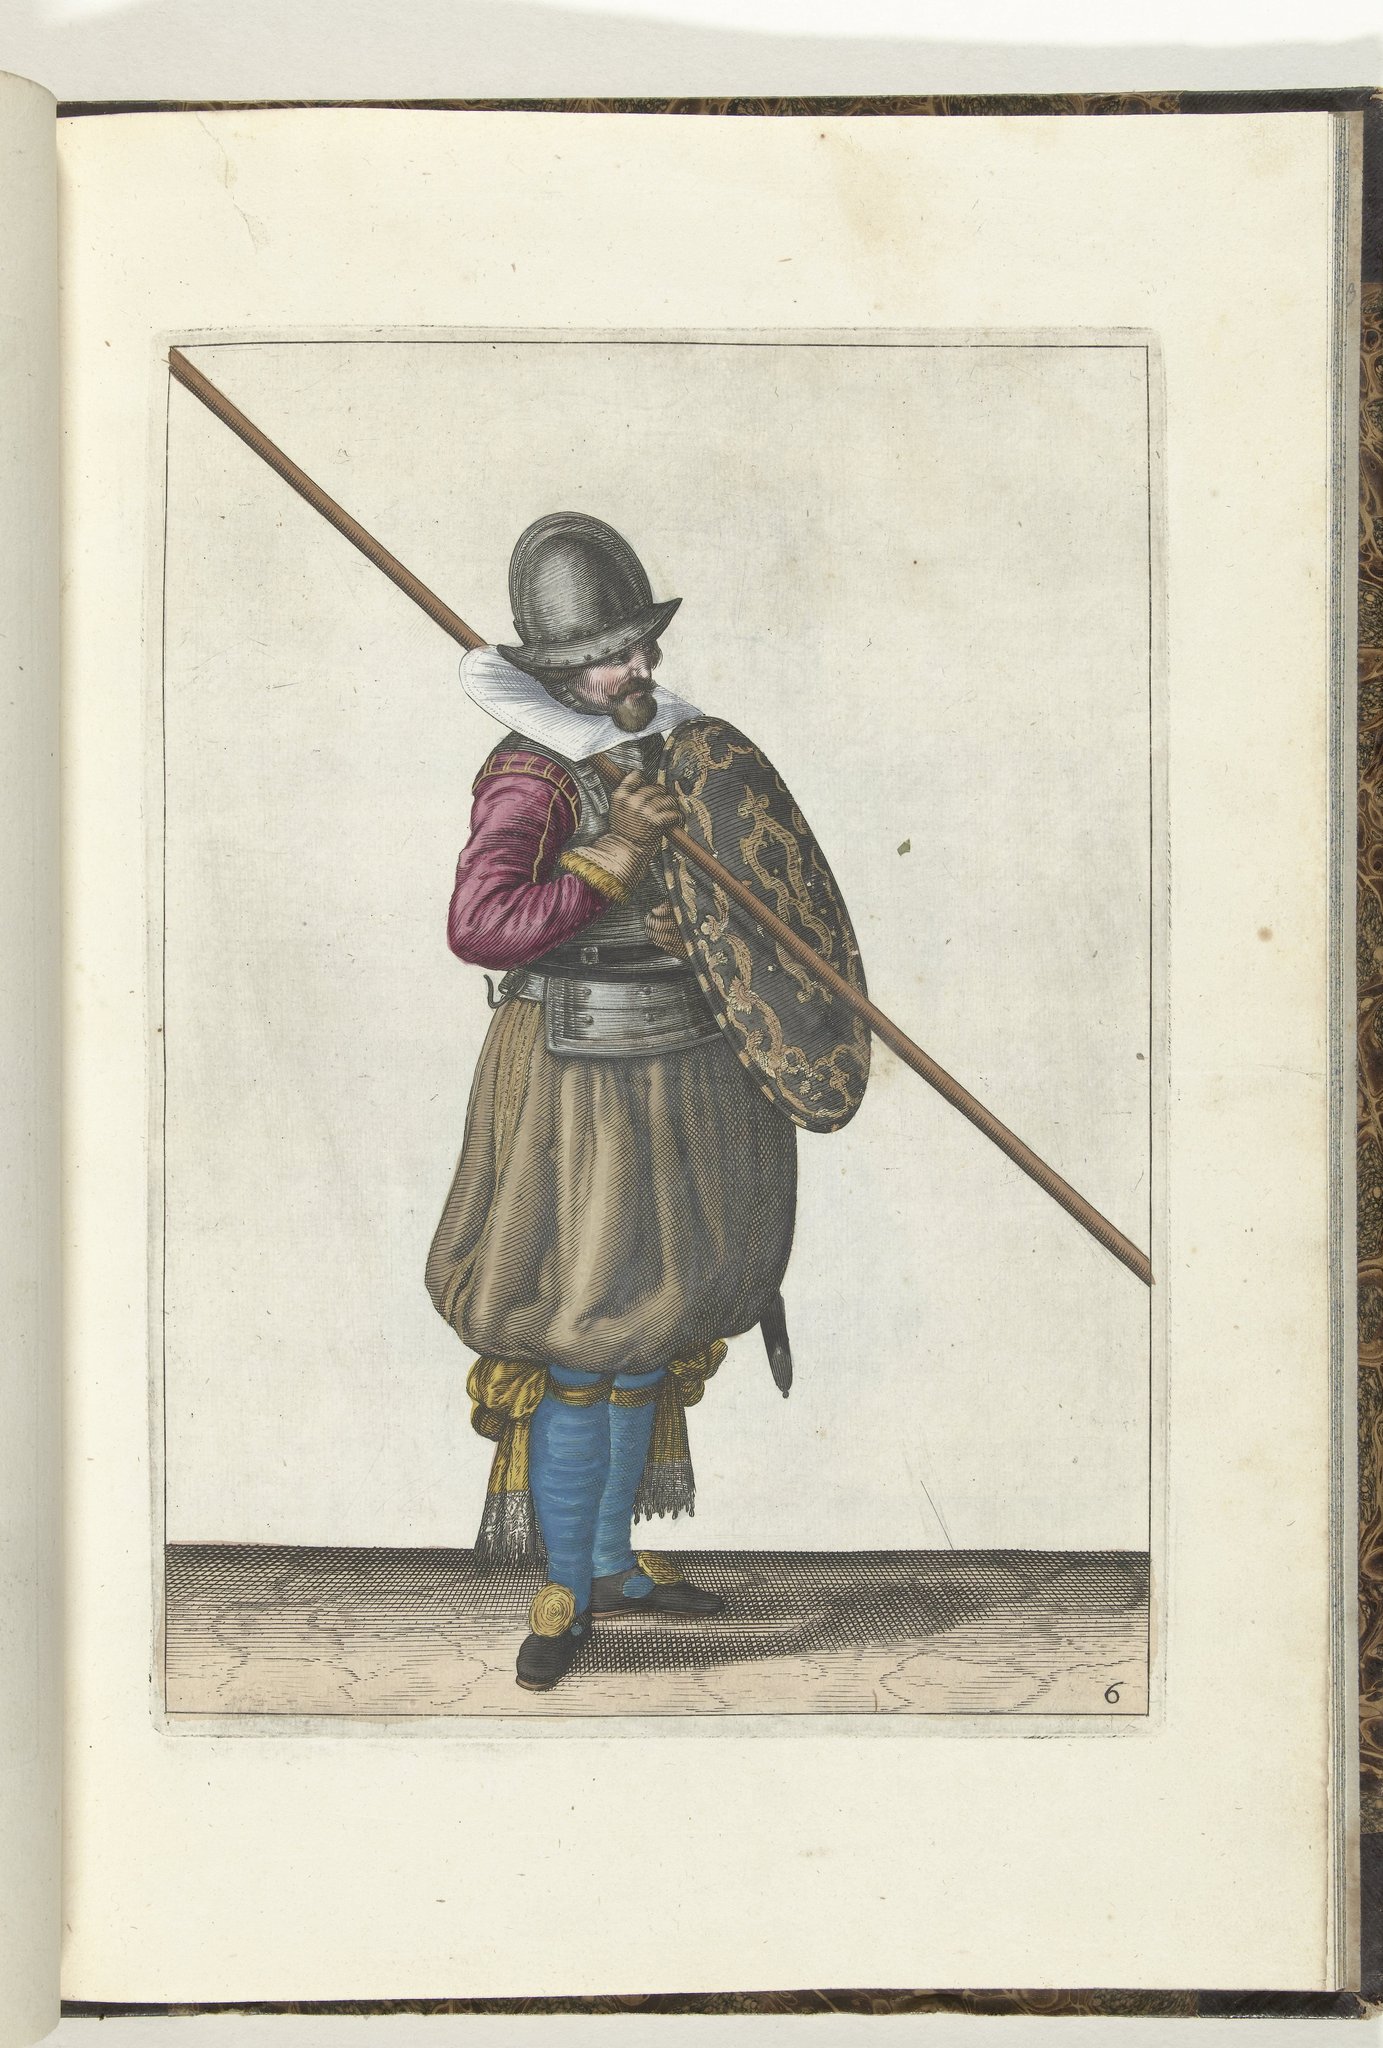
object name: print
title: De exercitie met schild en spies: de soldaat houdt het schild met de linkerhand vóór het lichaam (nr. 6), 1618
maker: Anonymous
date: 1616-1618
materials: paper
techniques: engraving, hand coloring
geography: northern netherlands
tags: the hague, maurice (prince of orange), handling of weapons ~ military training, weapons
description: Illustratie in: Adam van Breen, Nassauische Waffenhandelung [incompleet exemplaar], 1618?, plaat 6. Dit is een Duitse editie van Adam van Breens De Nassausche Wapen-Handelinge, van Schilt, Spies, Rappier ende Targe : beyde figuerlick afgebeelt, ende gestelt na de nieu ordening [van] ... Maurits van Nassau, 's-Gravenhage, [Aert Meuris] 1618. In het exemplaar in de collectie van de Rijksmuseum Research Library (326 F 23).